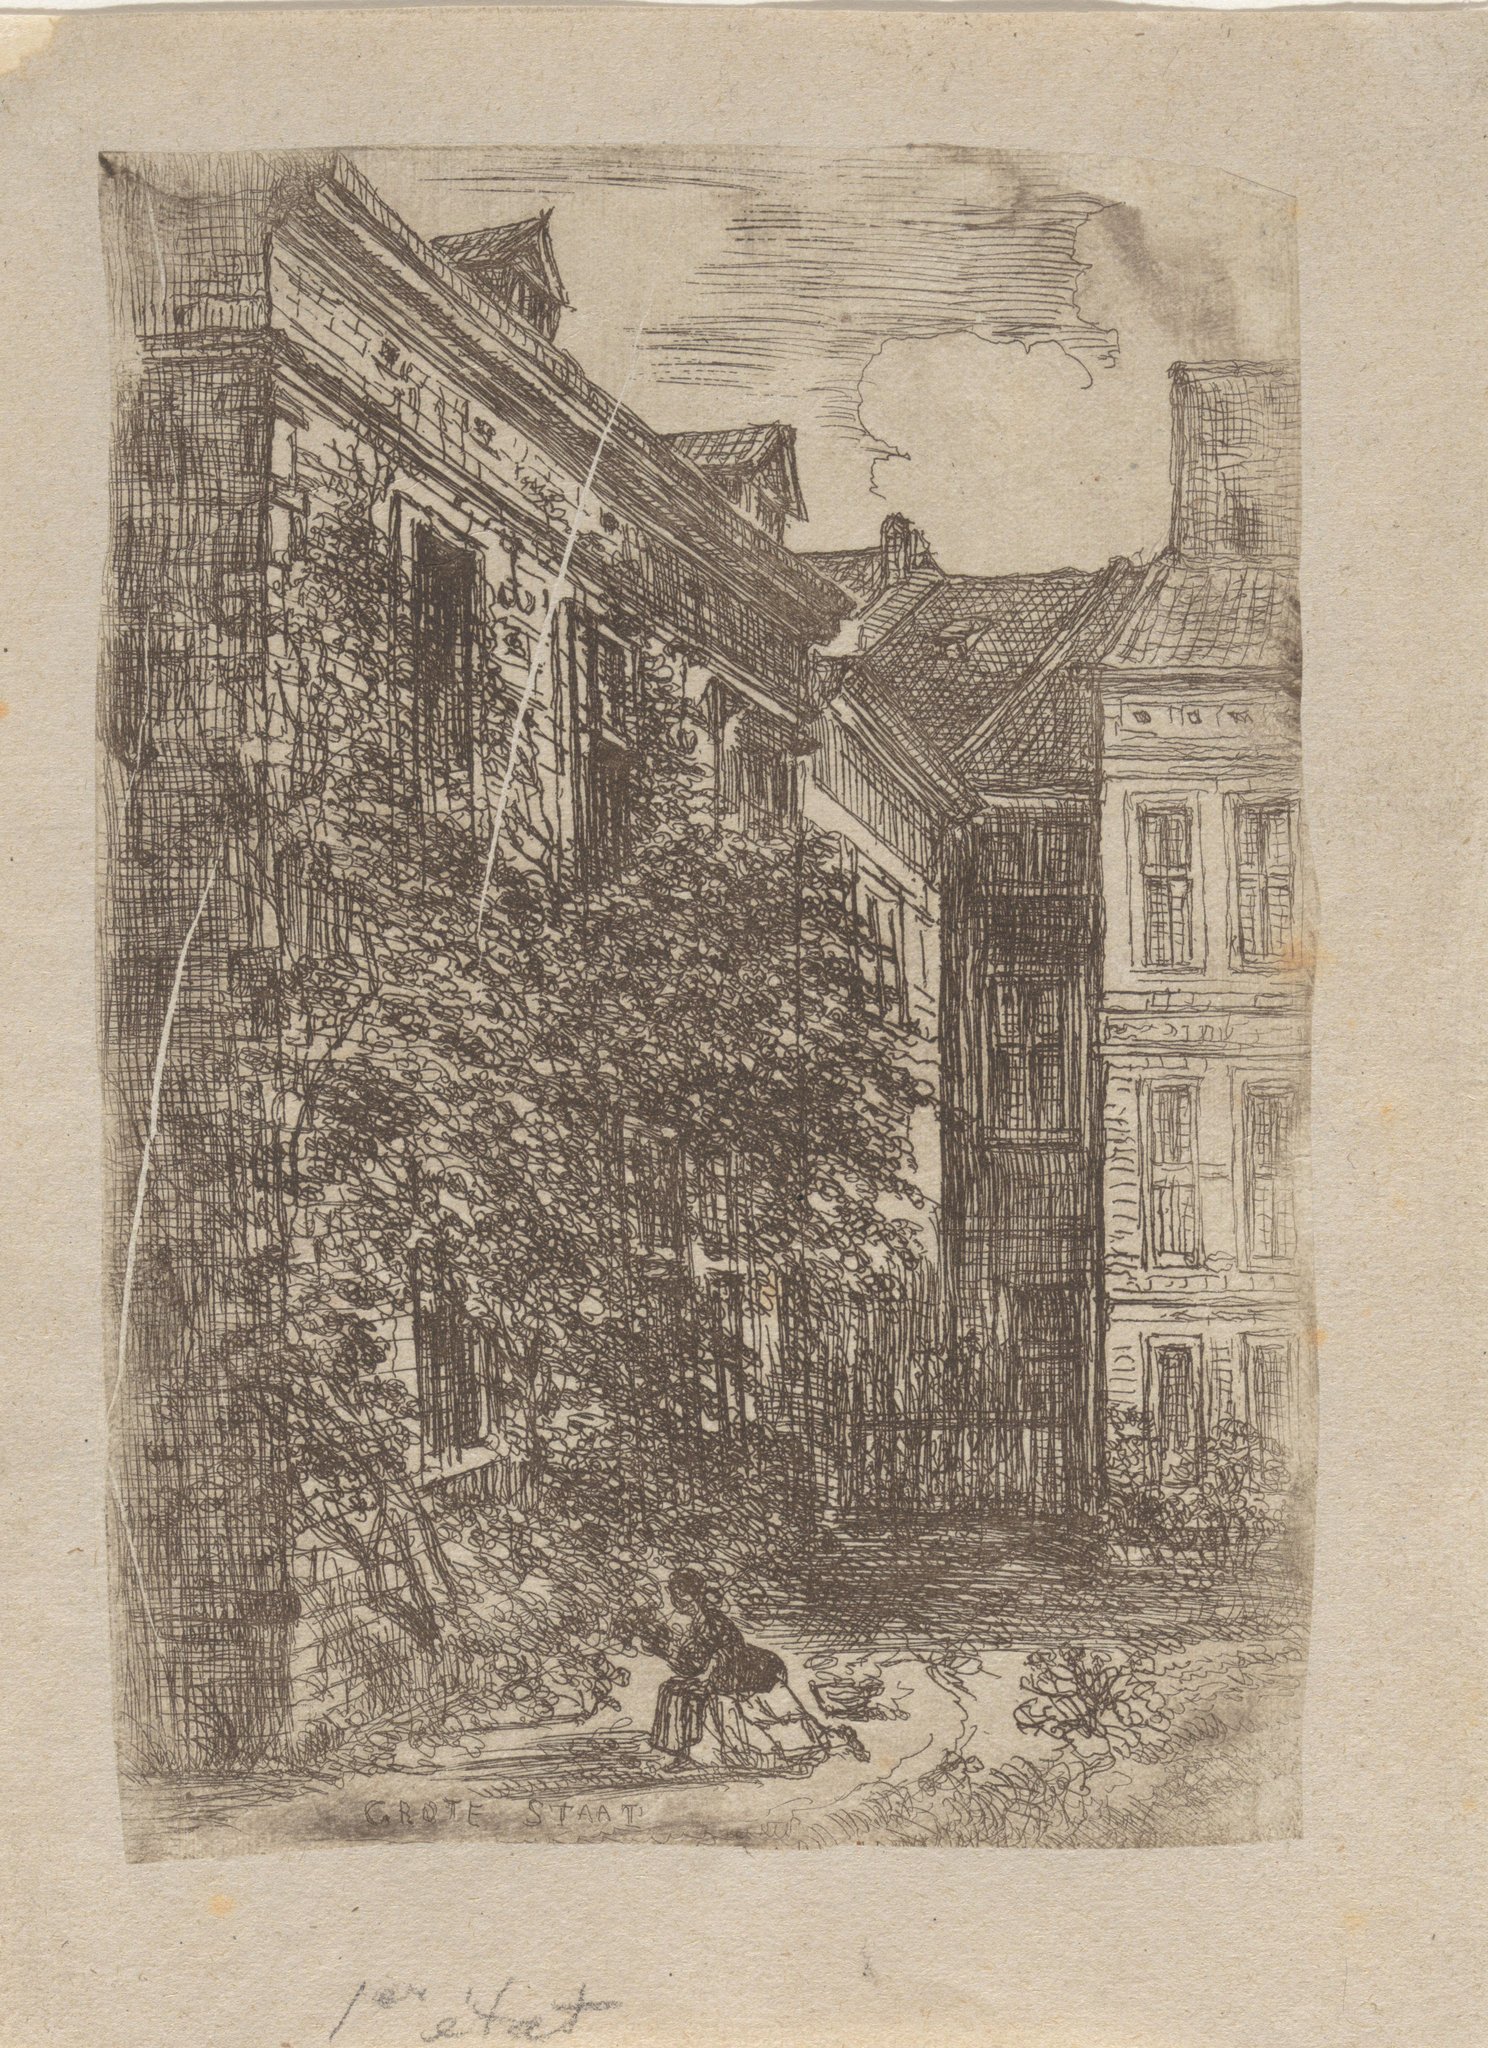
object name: print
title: Grote Staat te Maastricht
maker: alexander schaepkens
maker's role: draughtsman, print maker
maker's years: 1815-1899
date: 1830-1899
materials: paper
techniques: etching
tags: street, maastricht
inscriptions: collector's mark: Lugt 2228